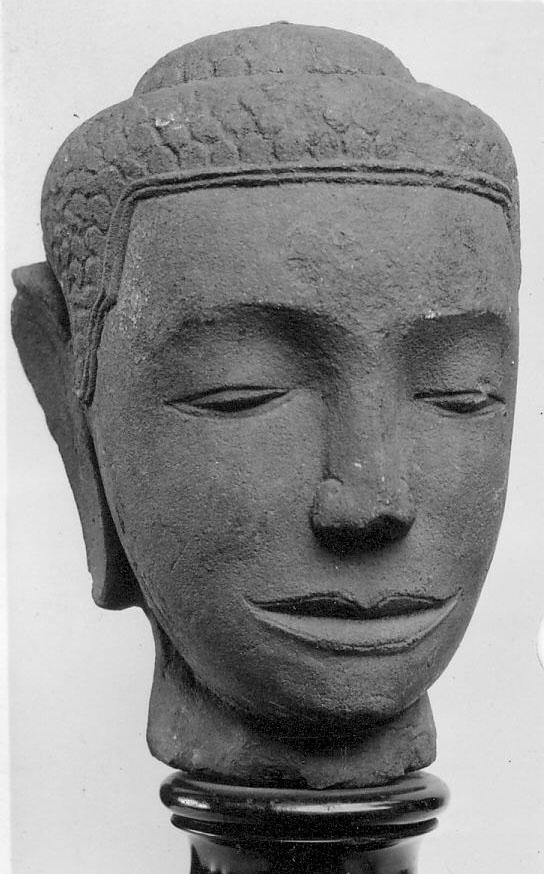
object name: head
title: Head of a Buddha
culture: cambodian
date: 901-1000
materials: stone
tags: heads,buddhism,buddha